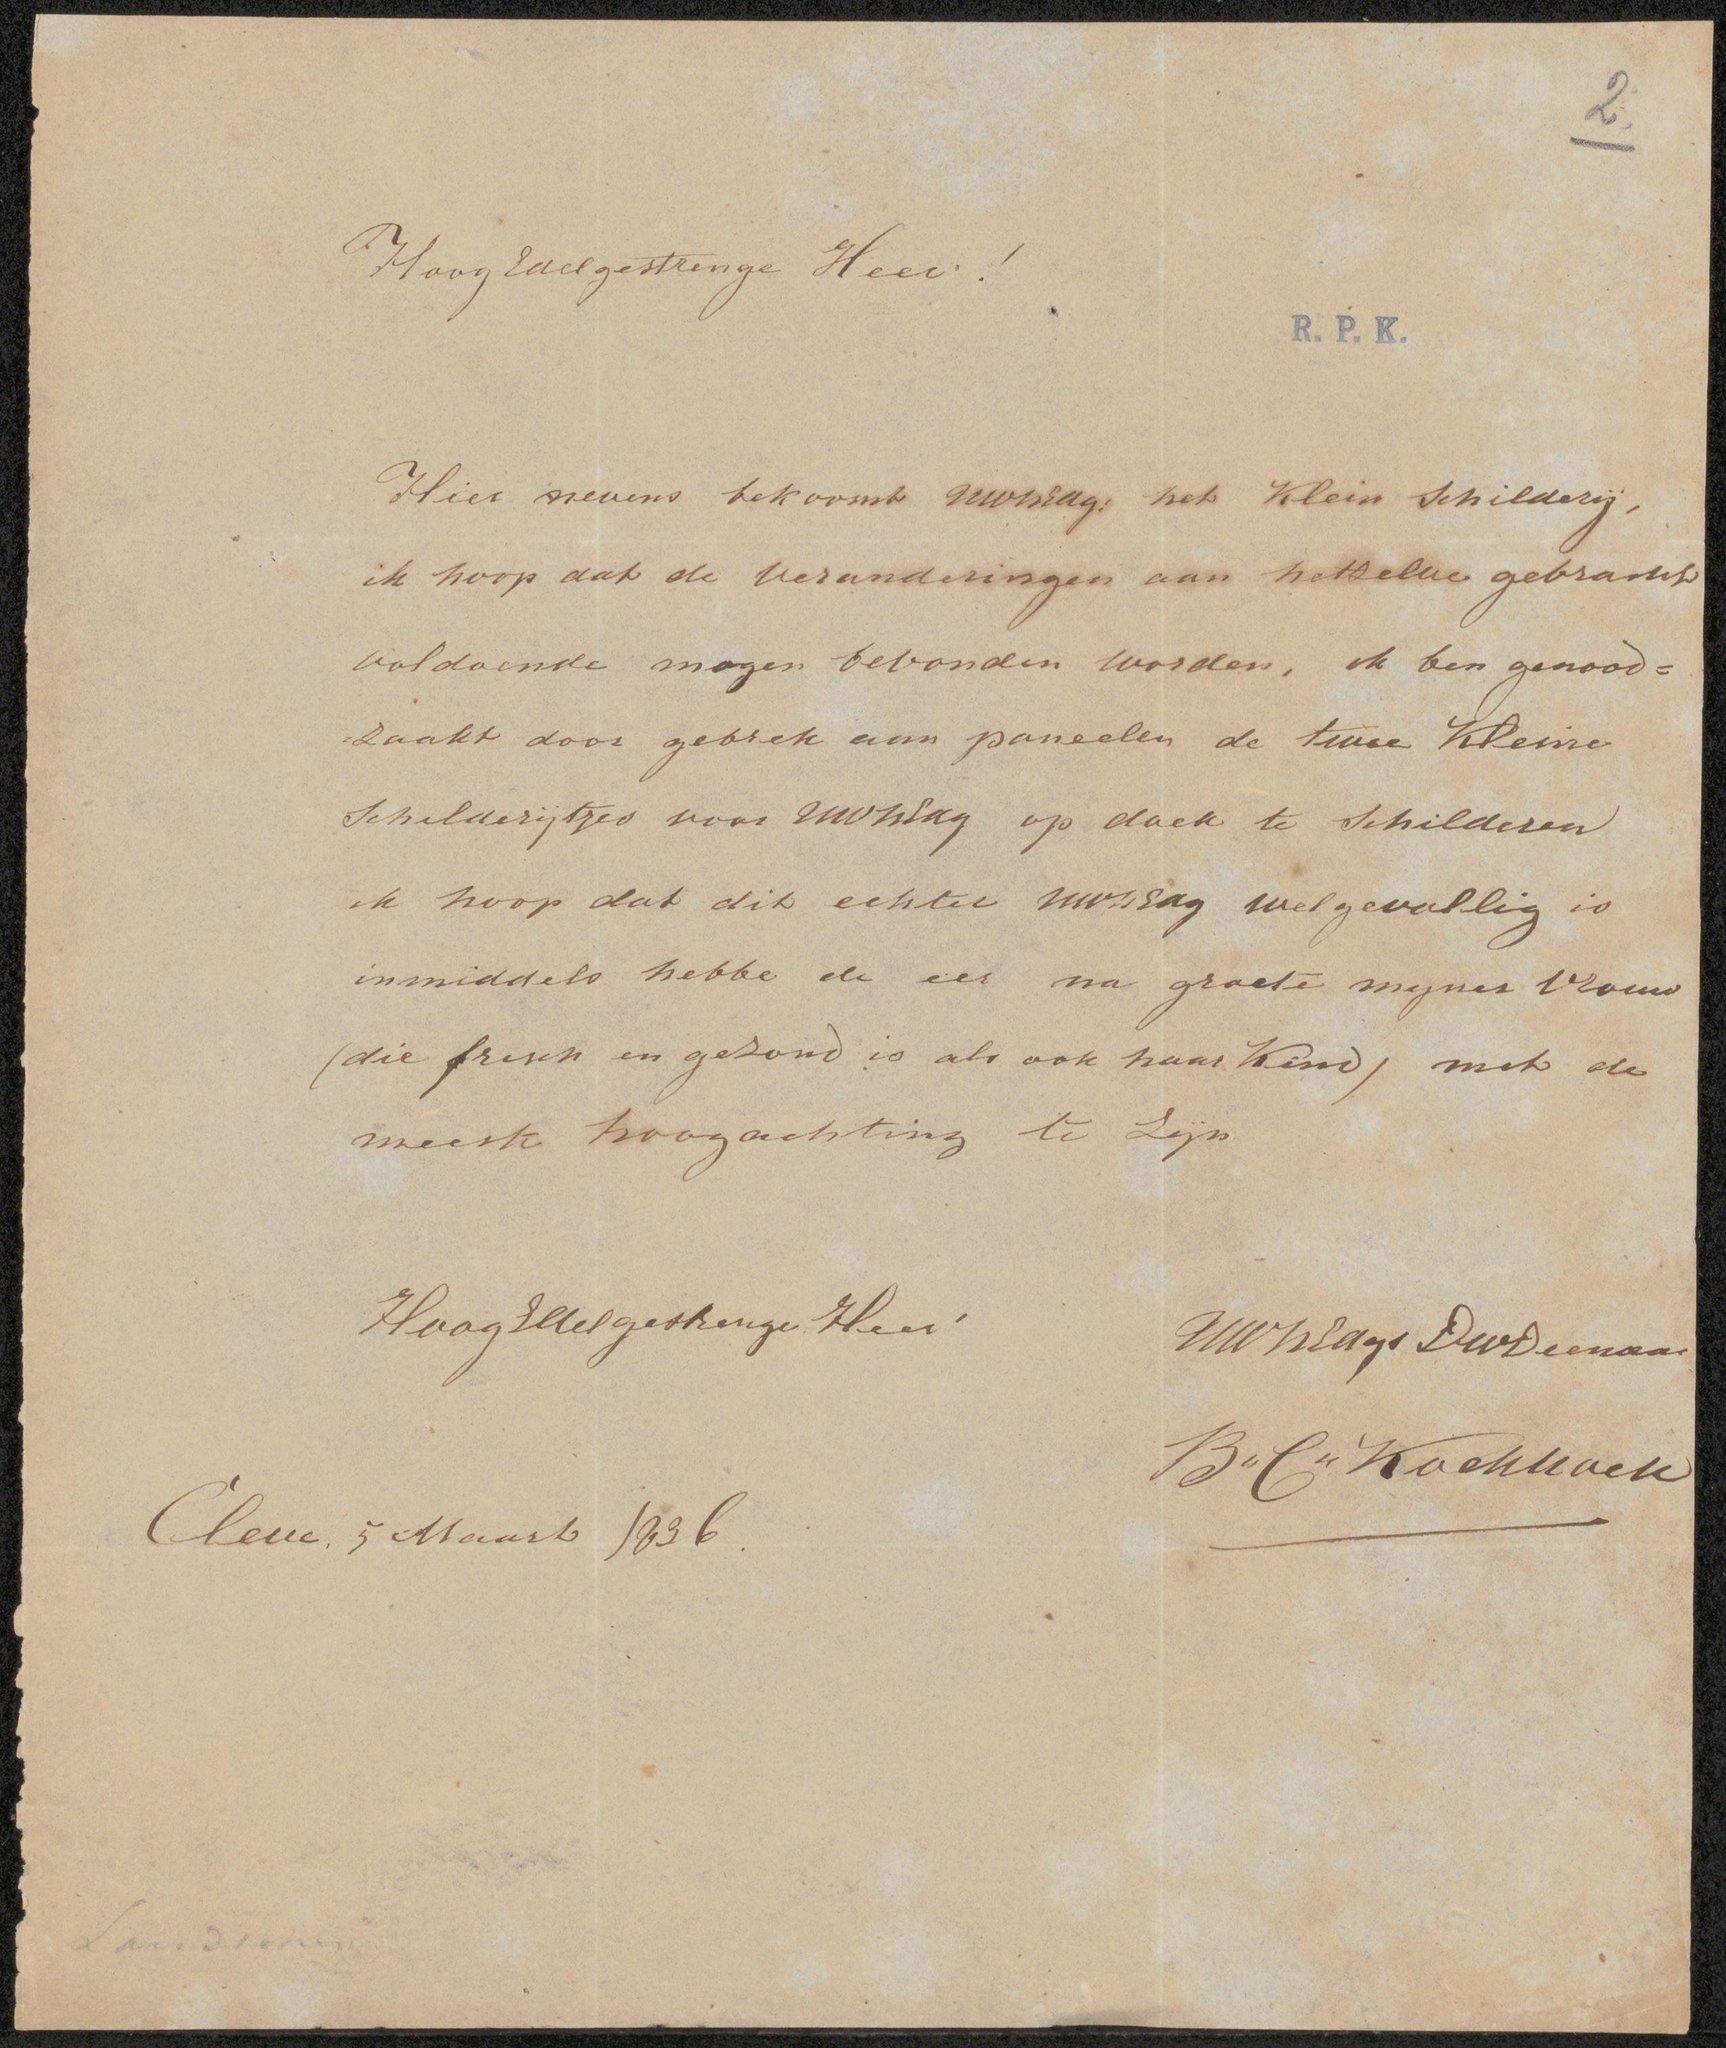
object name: letter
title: Brief aan anoniem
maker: barend cornelis koekkoek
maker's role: draughtsman, painter, print maker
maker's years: 1803-1862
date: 1836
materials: ink, paper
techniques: pen, writing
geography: cleves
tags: family life, painting (including book-illumination, miniature-painting)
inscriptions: collector's mark: Lugt 2233